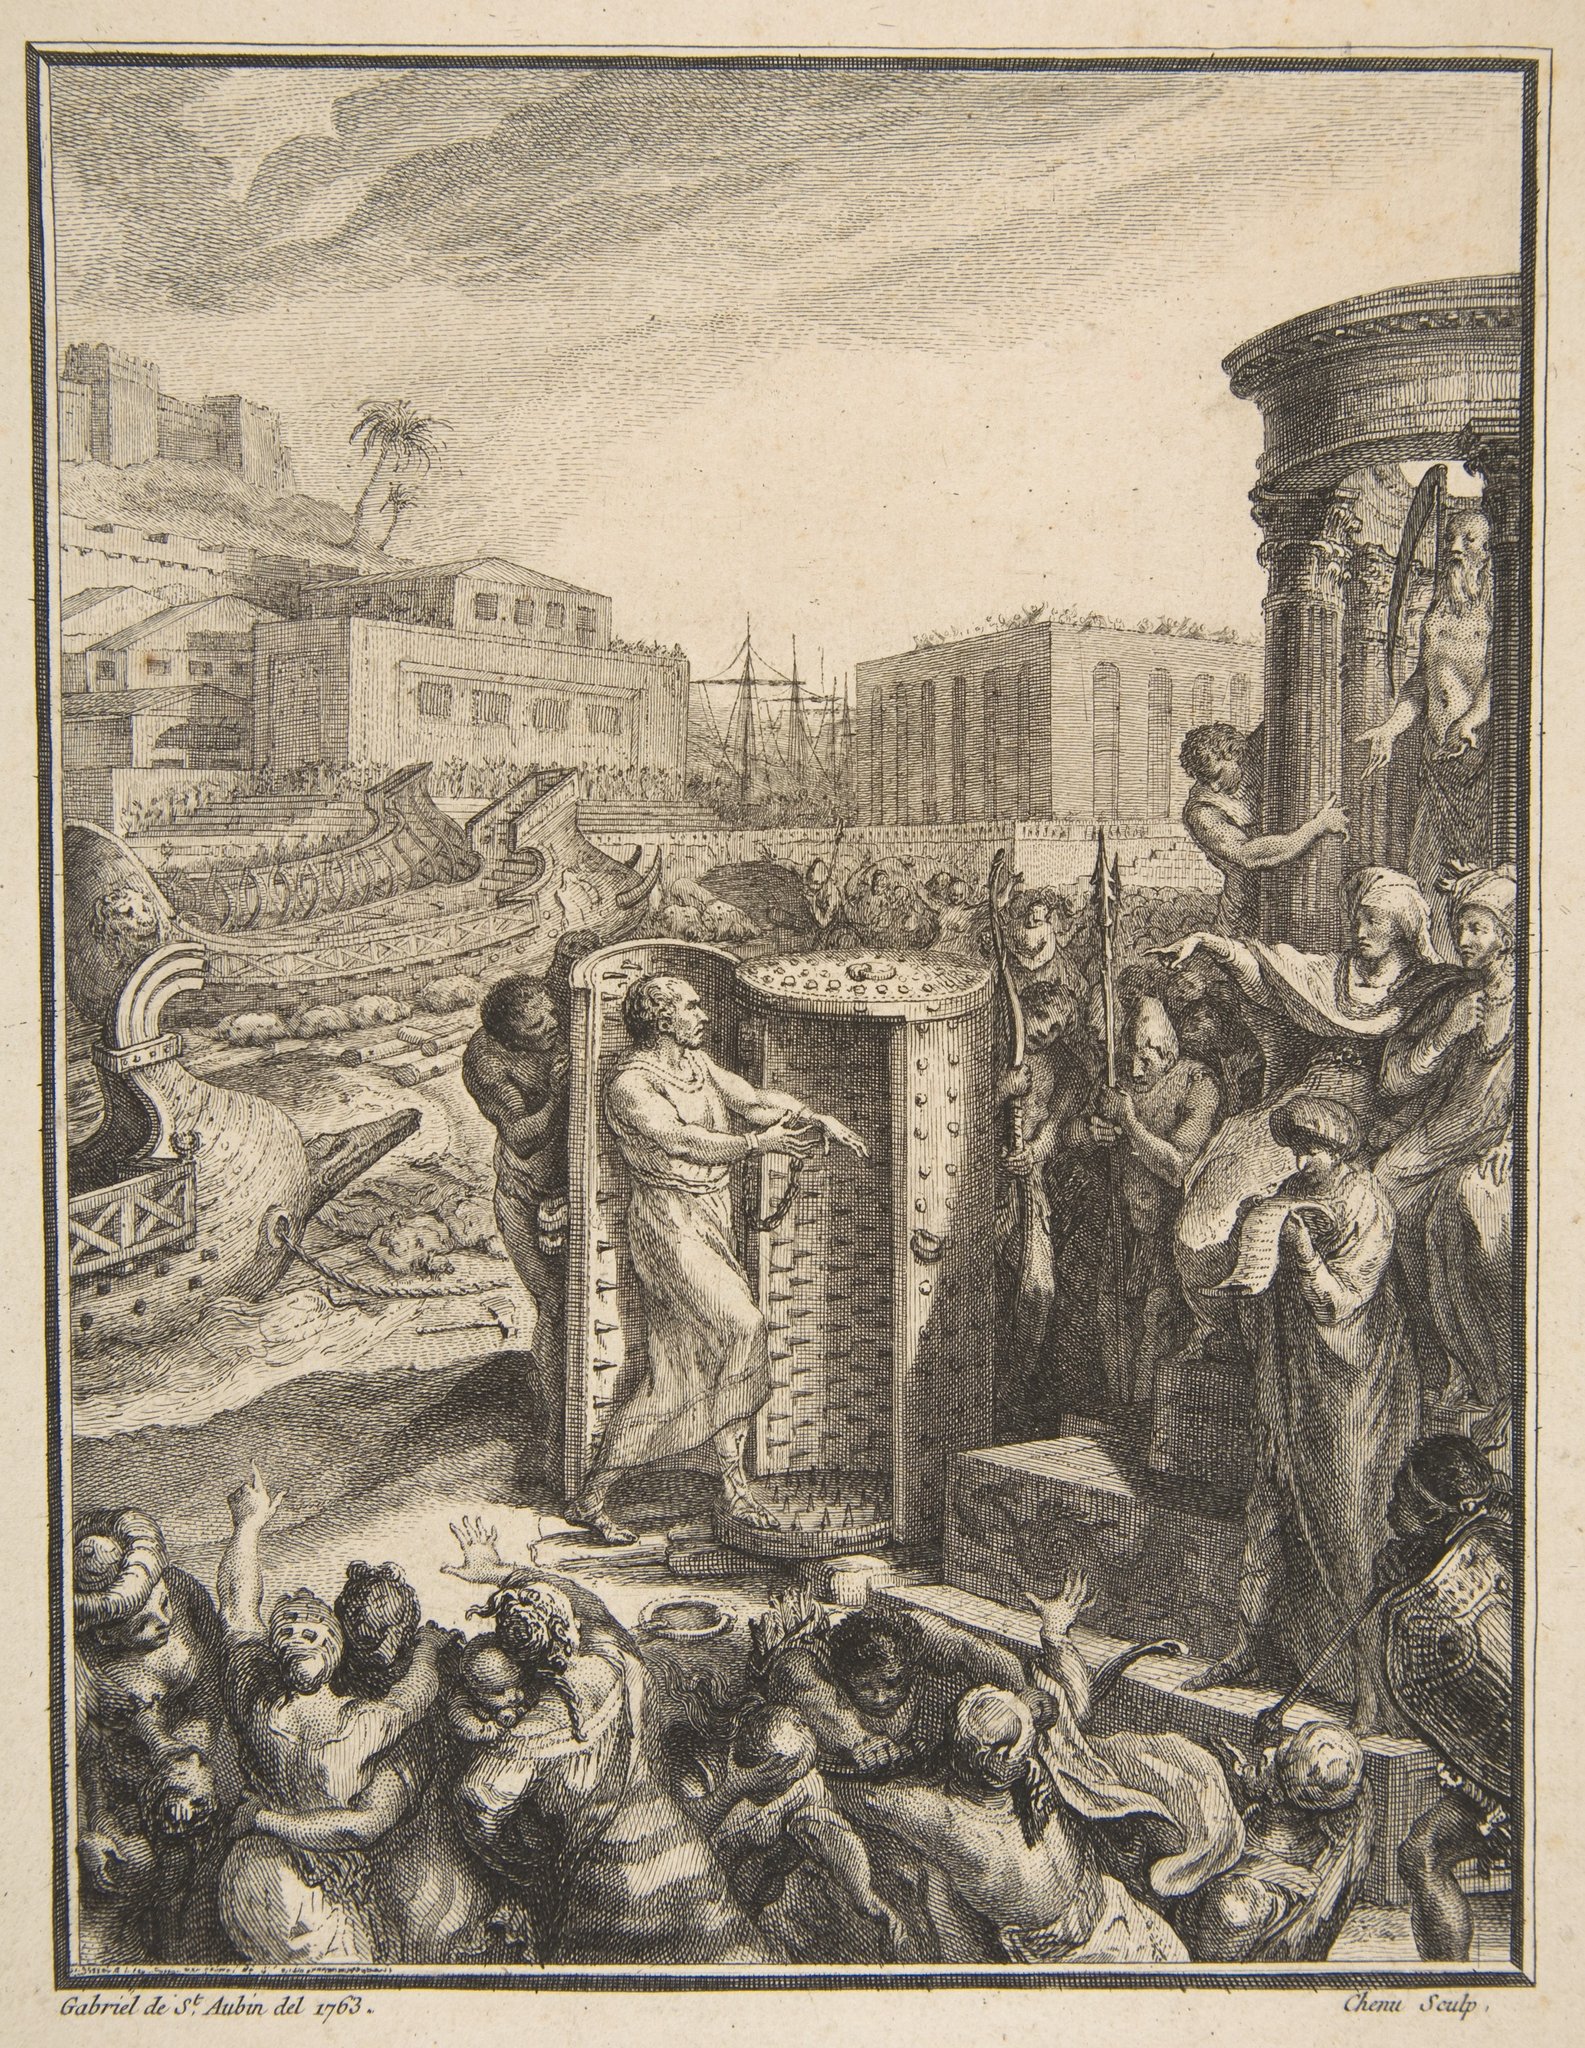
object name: print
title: Regulus Condemned to the Most Horrible Torture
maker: gabriel de saint-aubin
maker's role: artist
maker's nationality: french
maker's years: 1724-1780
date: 1701-1800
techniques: engraving, etching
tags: suffering,men,crowd,boats